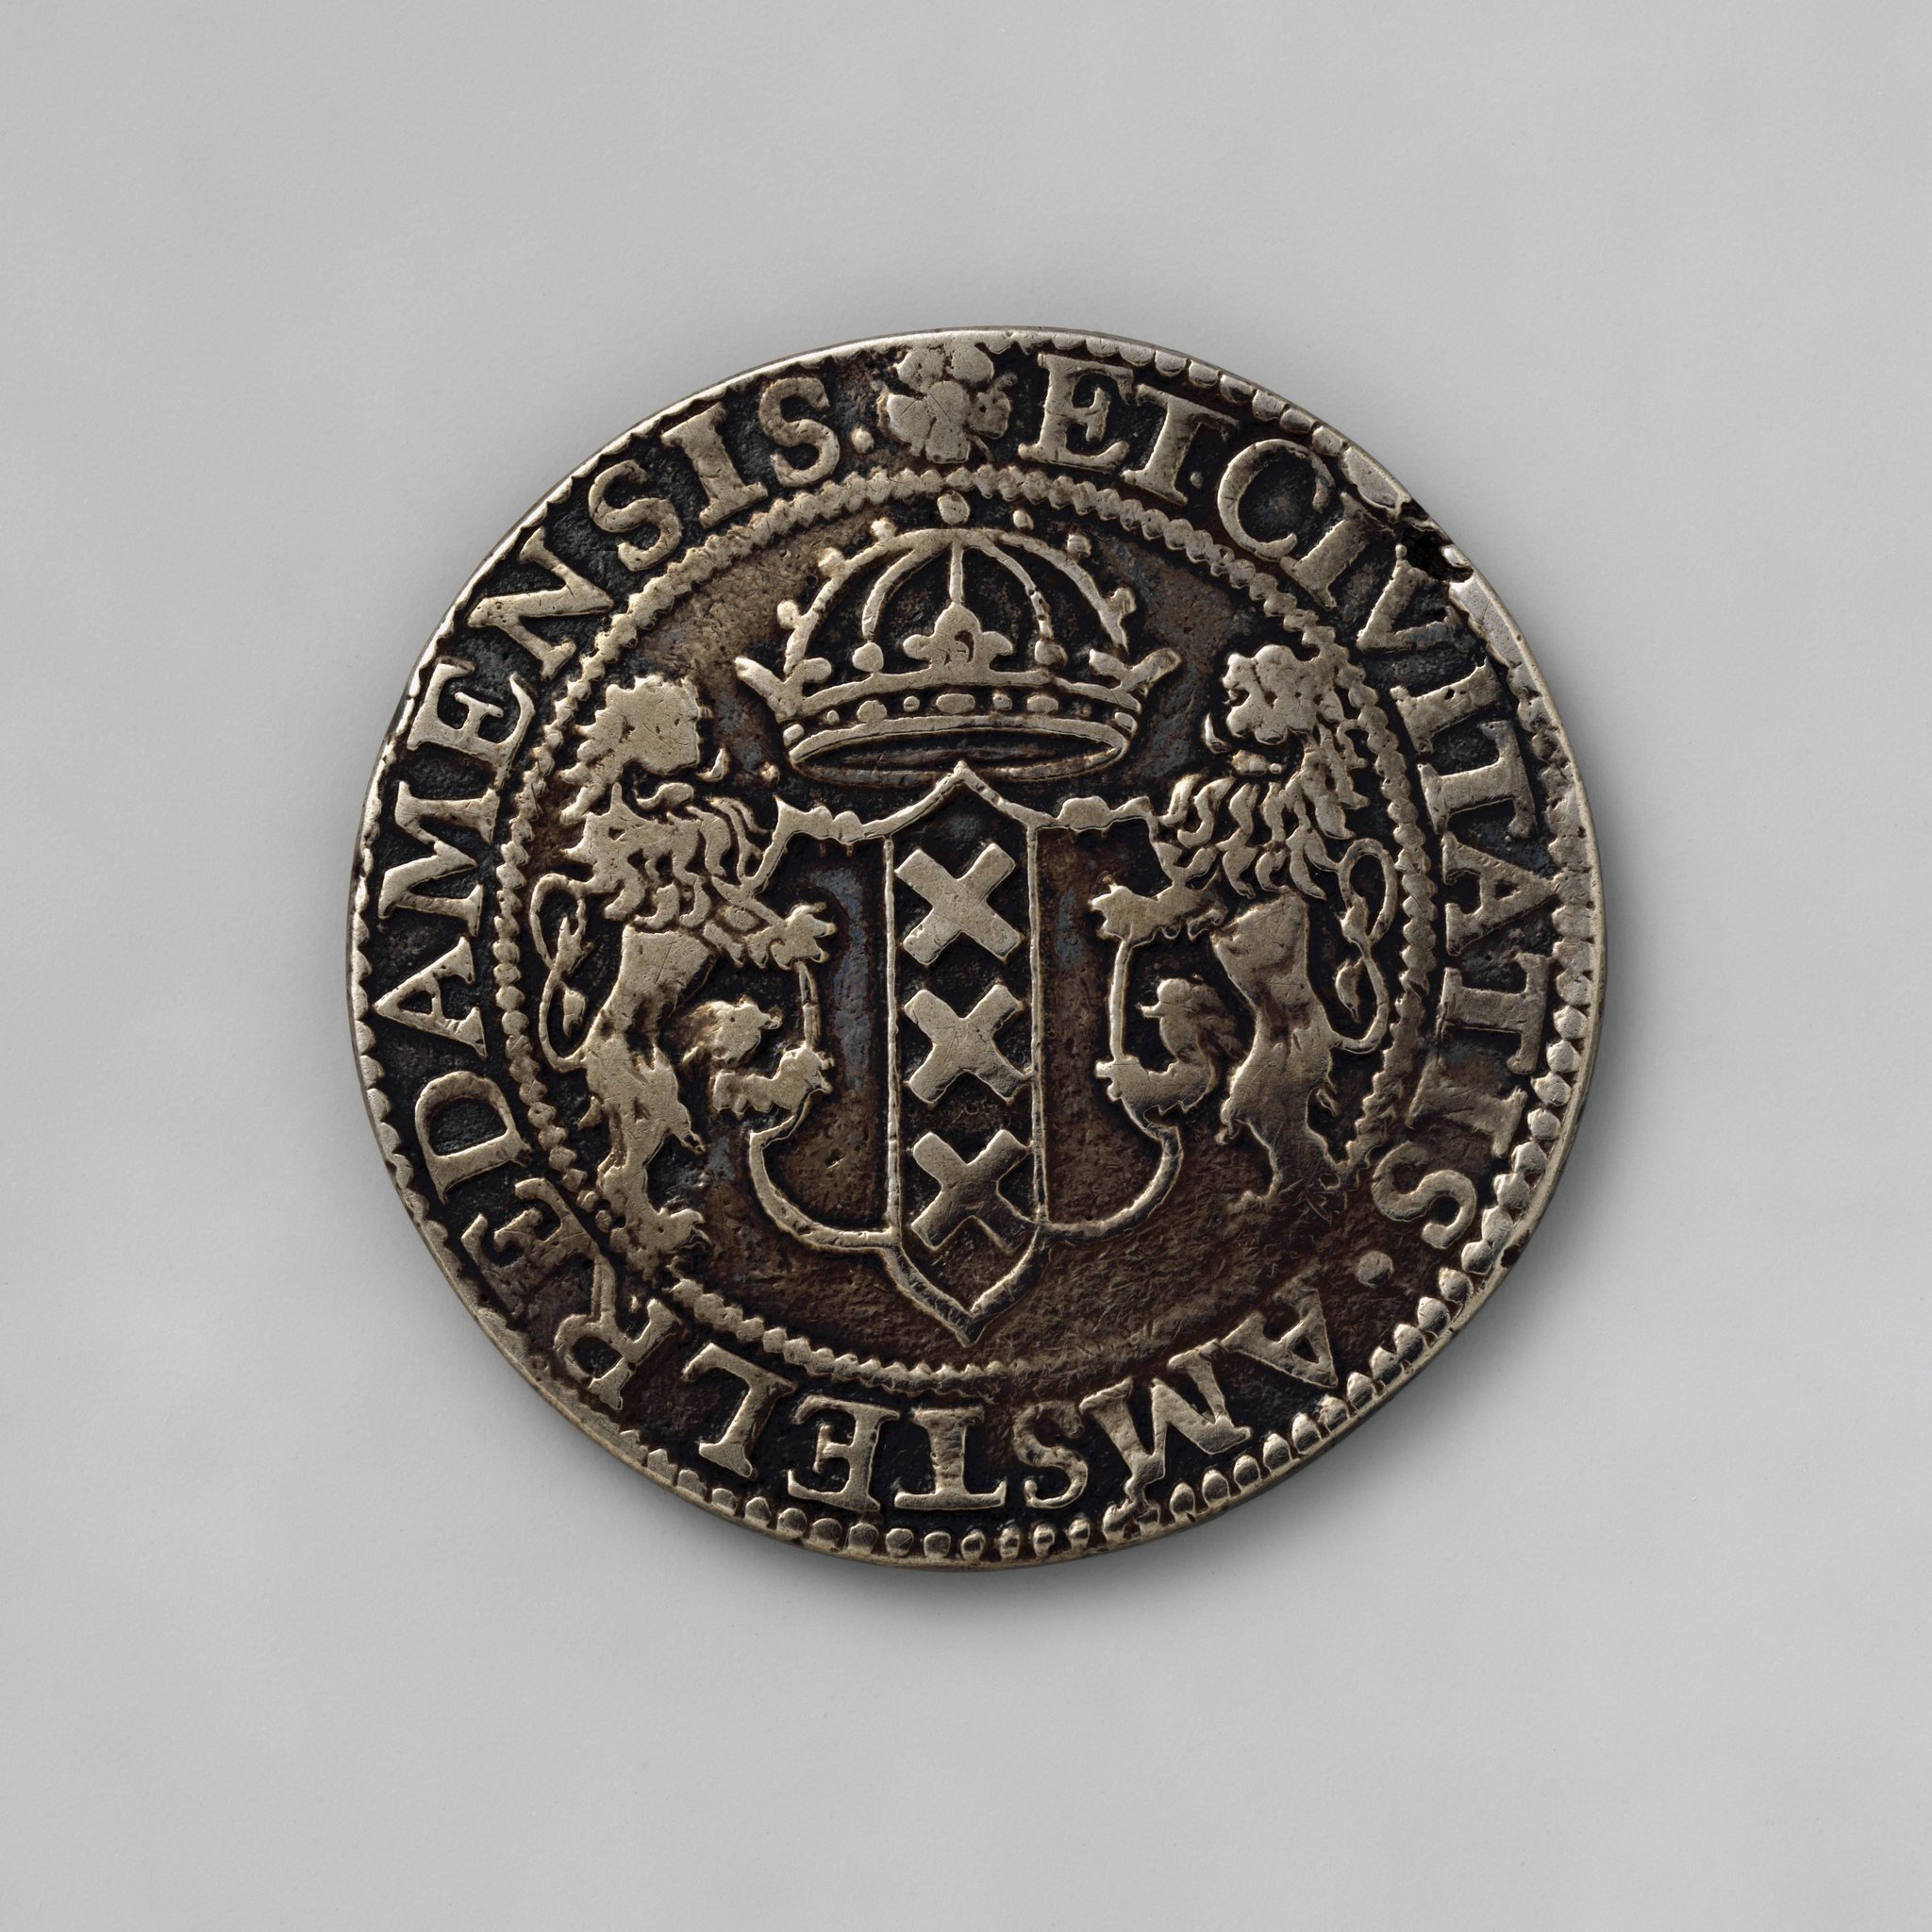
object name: acht reaal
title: Eight-real coin, Verenigde Amsterdamse Compagnie; dollar issued by a predecessor of the VOC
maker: Anonymous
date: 1601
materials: silver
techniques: striking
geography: dordrecht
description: Money often already existed in areas in Asia that the Netherlands conducted trade with and which became colonies. The Dutch occasionally used these original coins, which often look different from the European ones. At the same time, Dutch money was adapted for the colonies, and sometimes even entirely new coins were minted. The monetary system of the Dutch colonies in Asia and America was therefore a cultural mishmash.